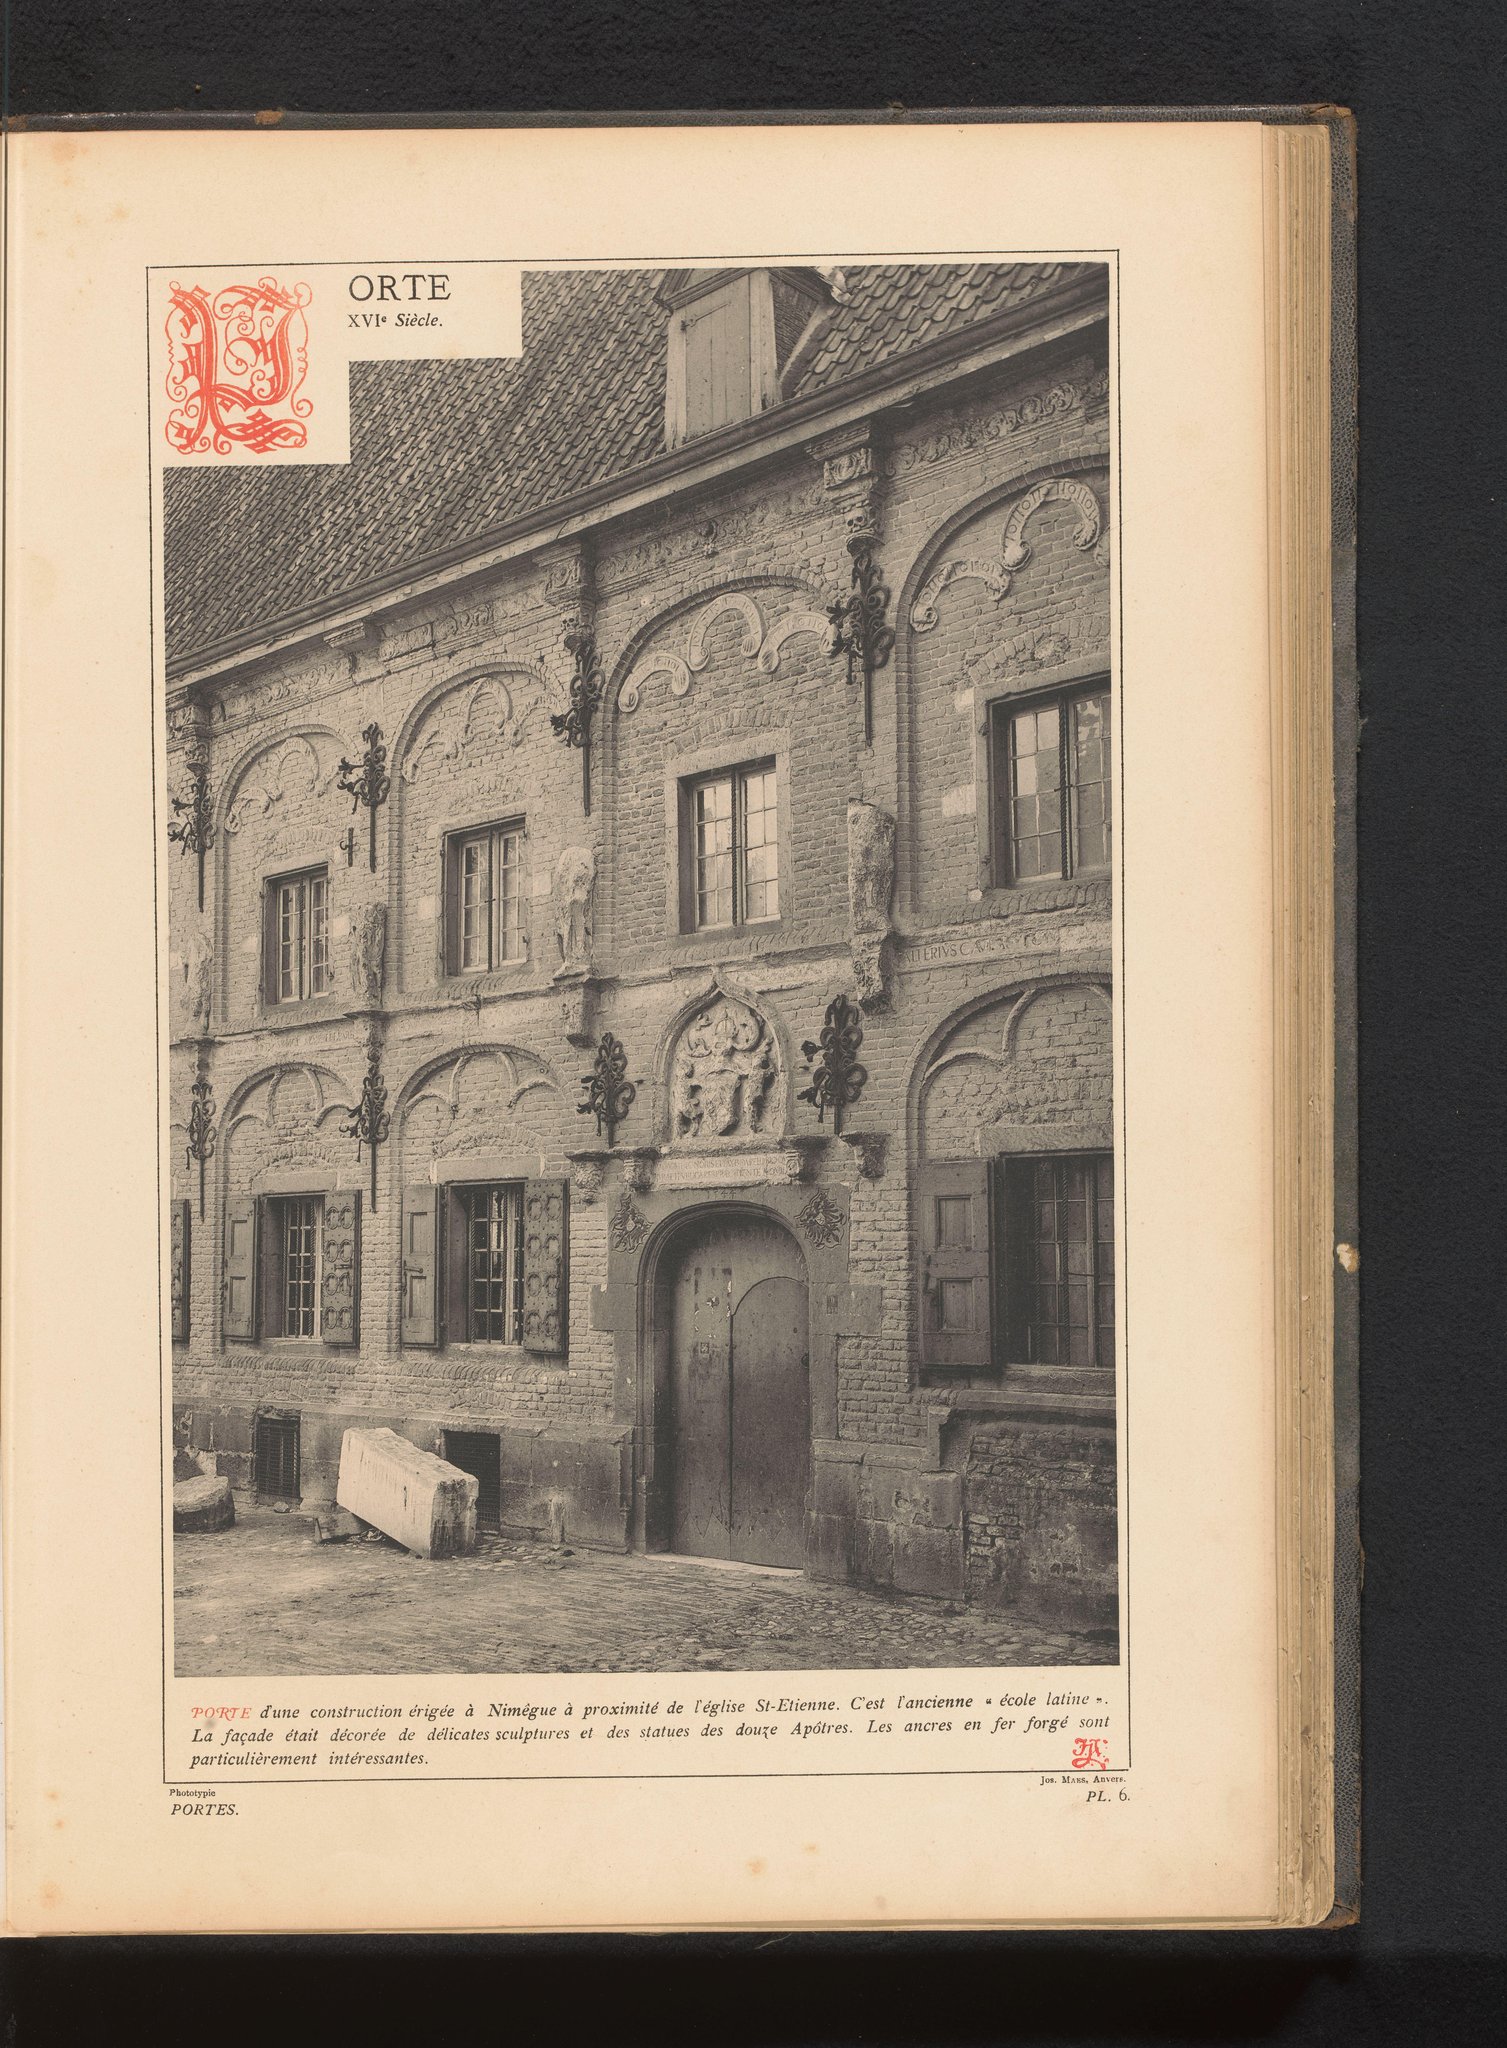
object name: page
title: Poort te Nijmegen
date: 1881-1889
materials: paper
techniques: photograph, photolithography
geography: nijmegen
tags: gate, entrance, civic architecture; edifices; dwellings, nijmegen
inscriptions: inscription: ‘PORTE d'une construction (...)’, monogram: ‘JJvY’, inscription: ‘PORTES. PL. 6.’